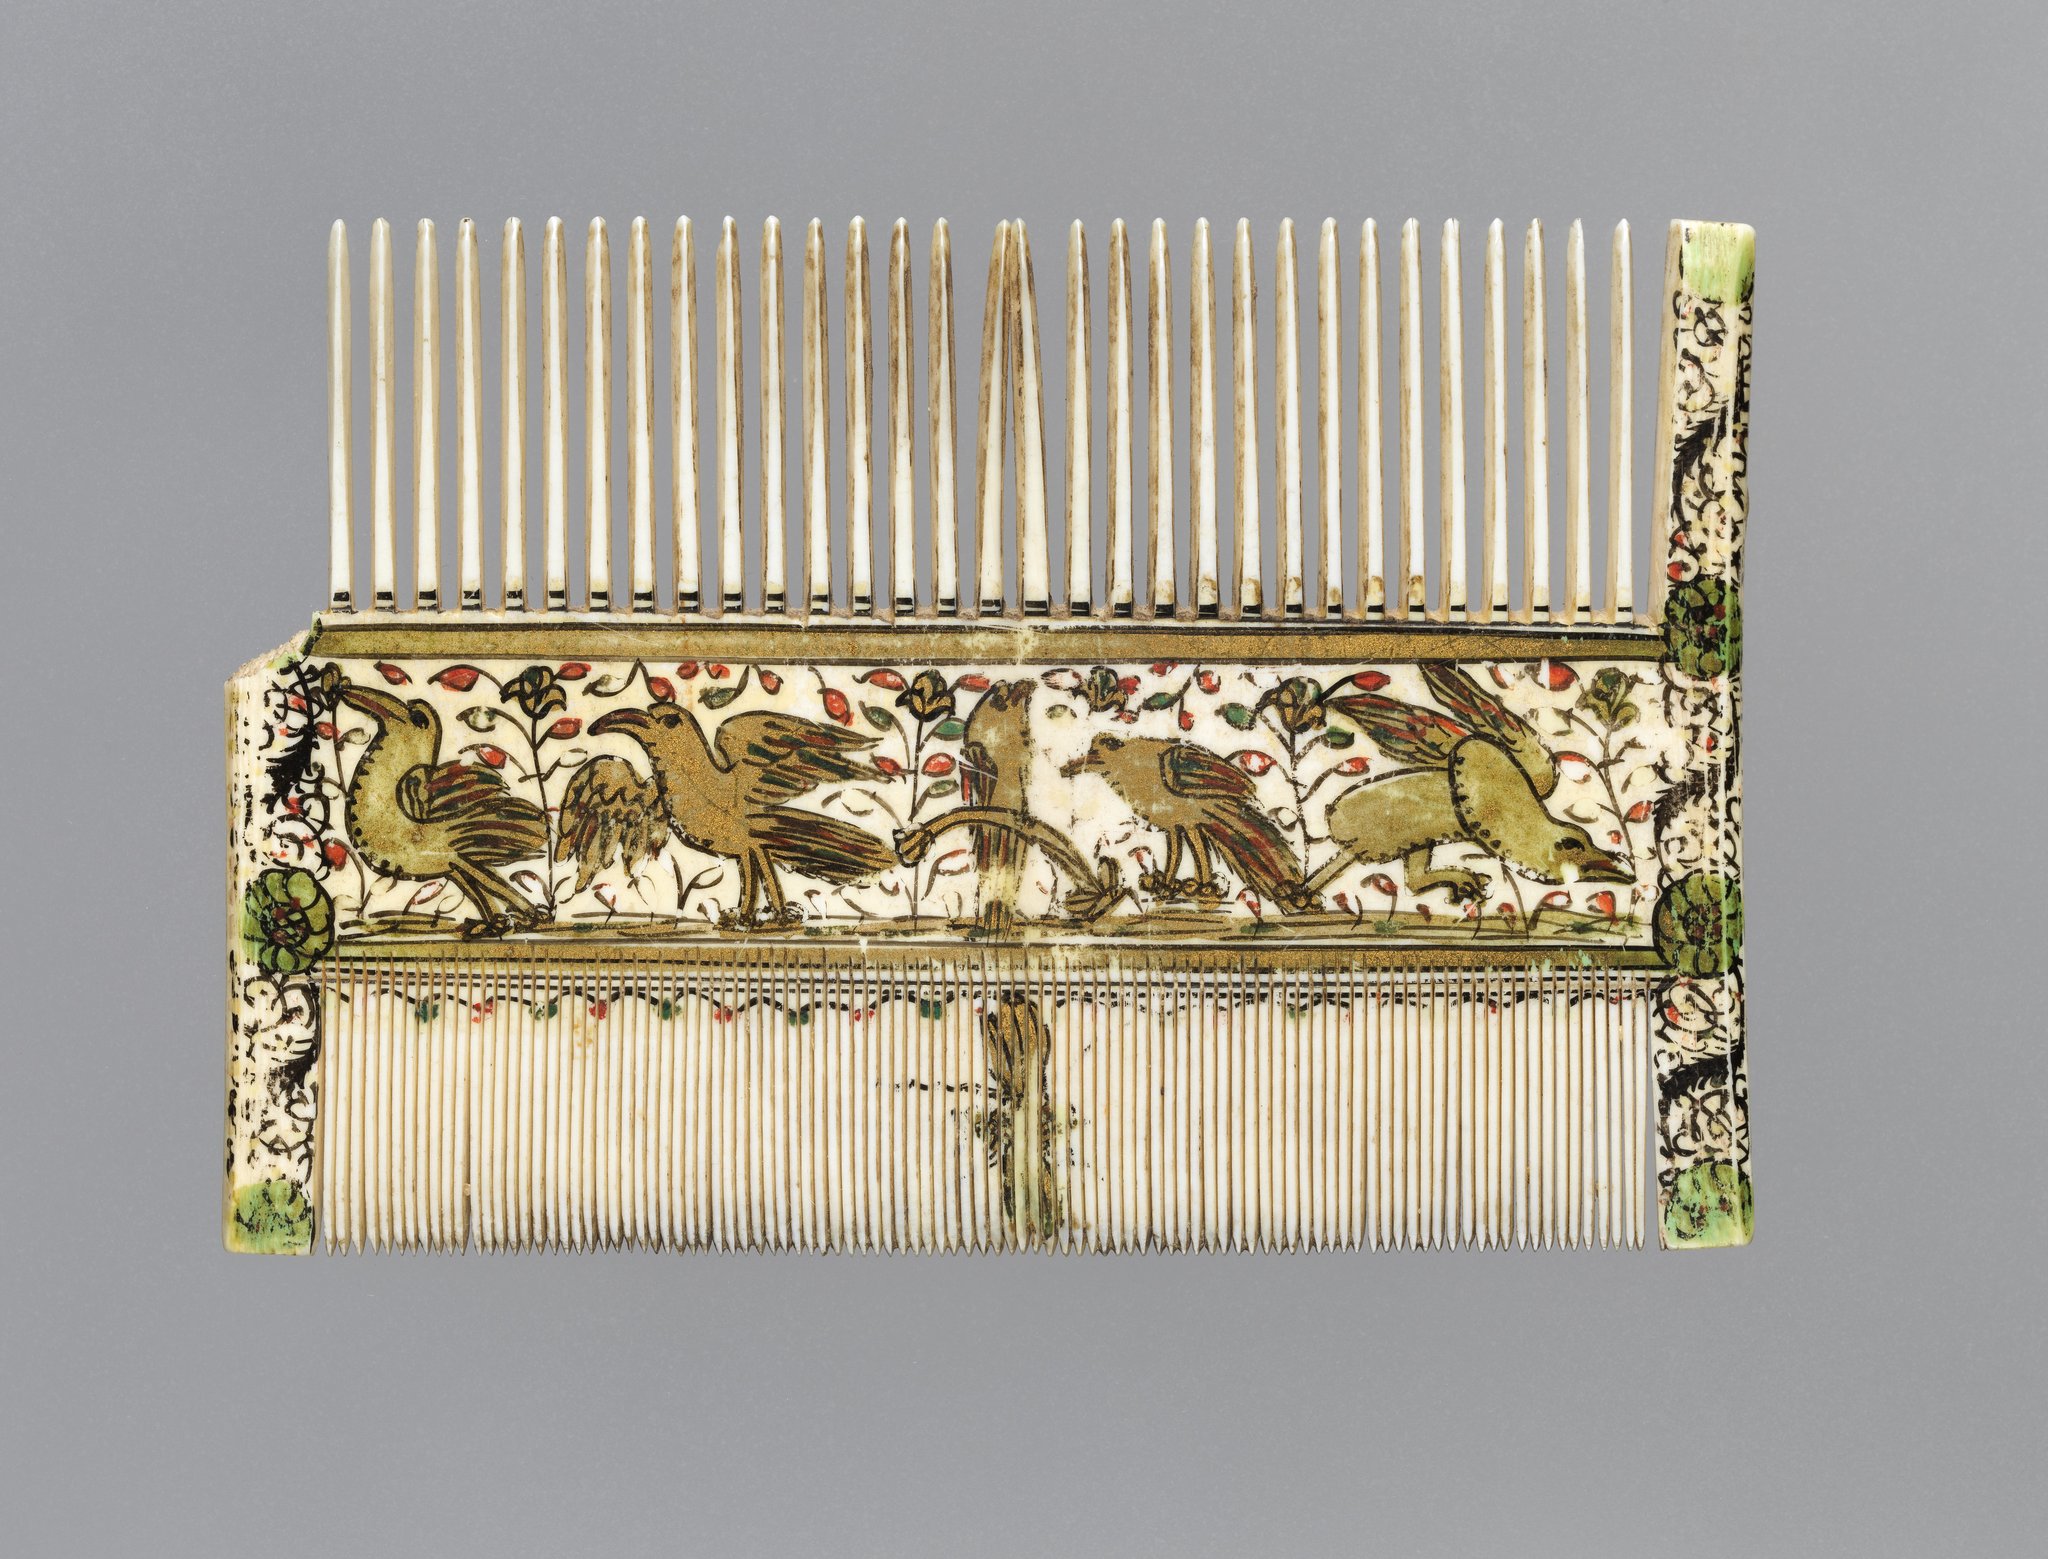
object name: comb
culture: french or italian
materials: ivory, paint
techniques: gilding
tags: birds